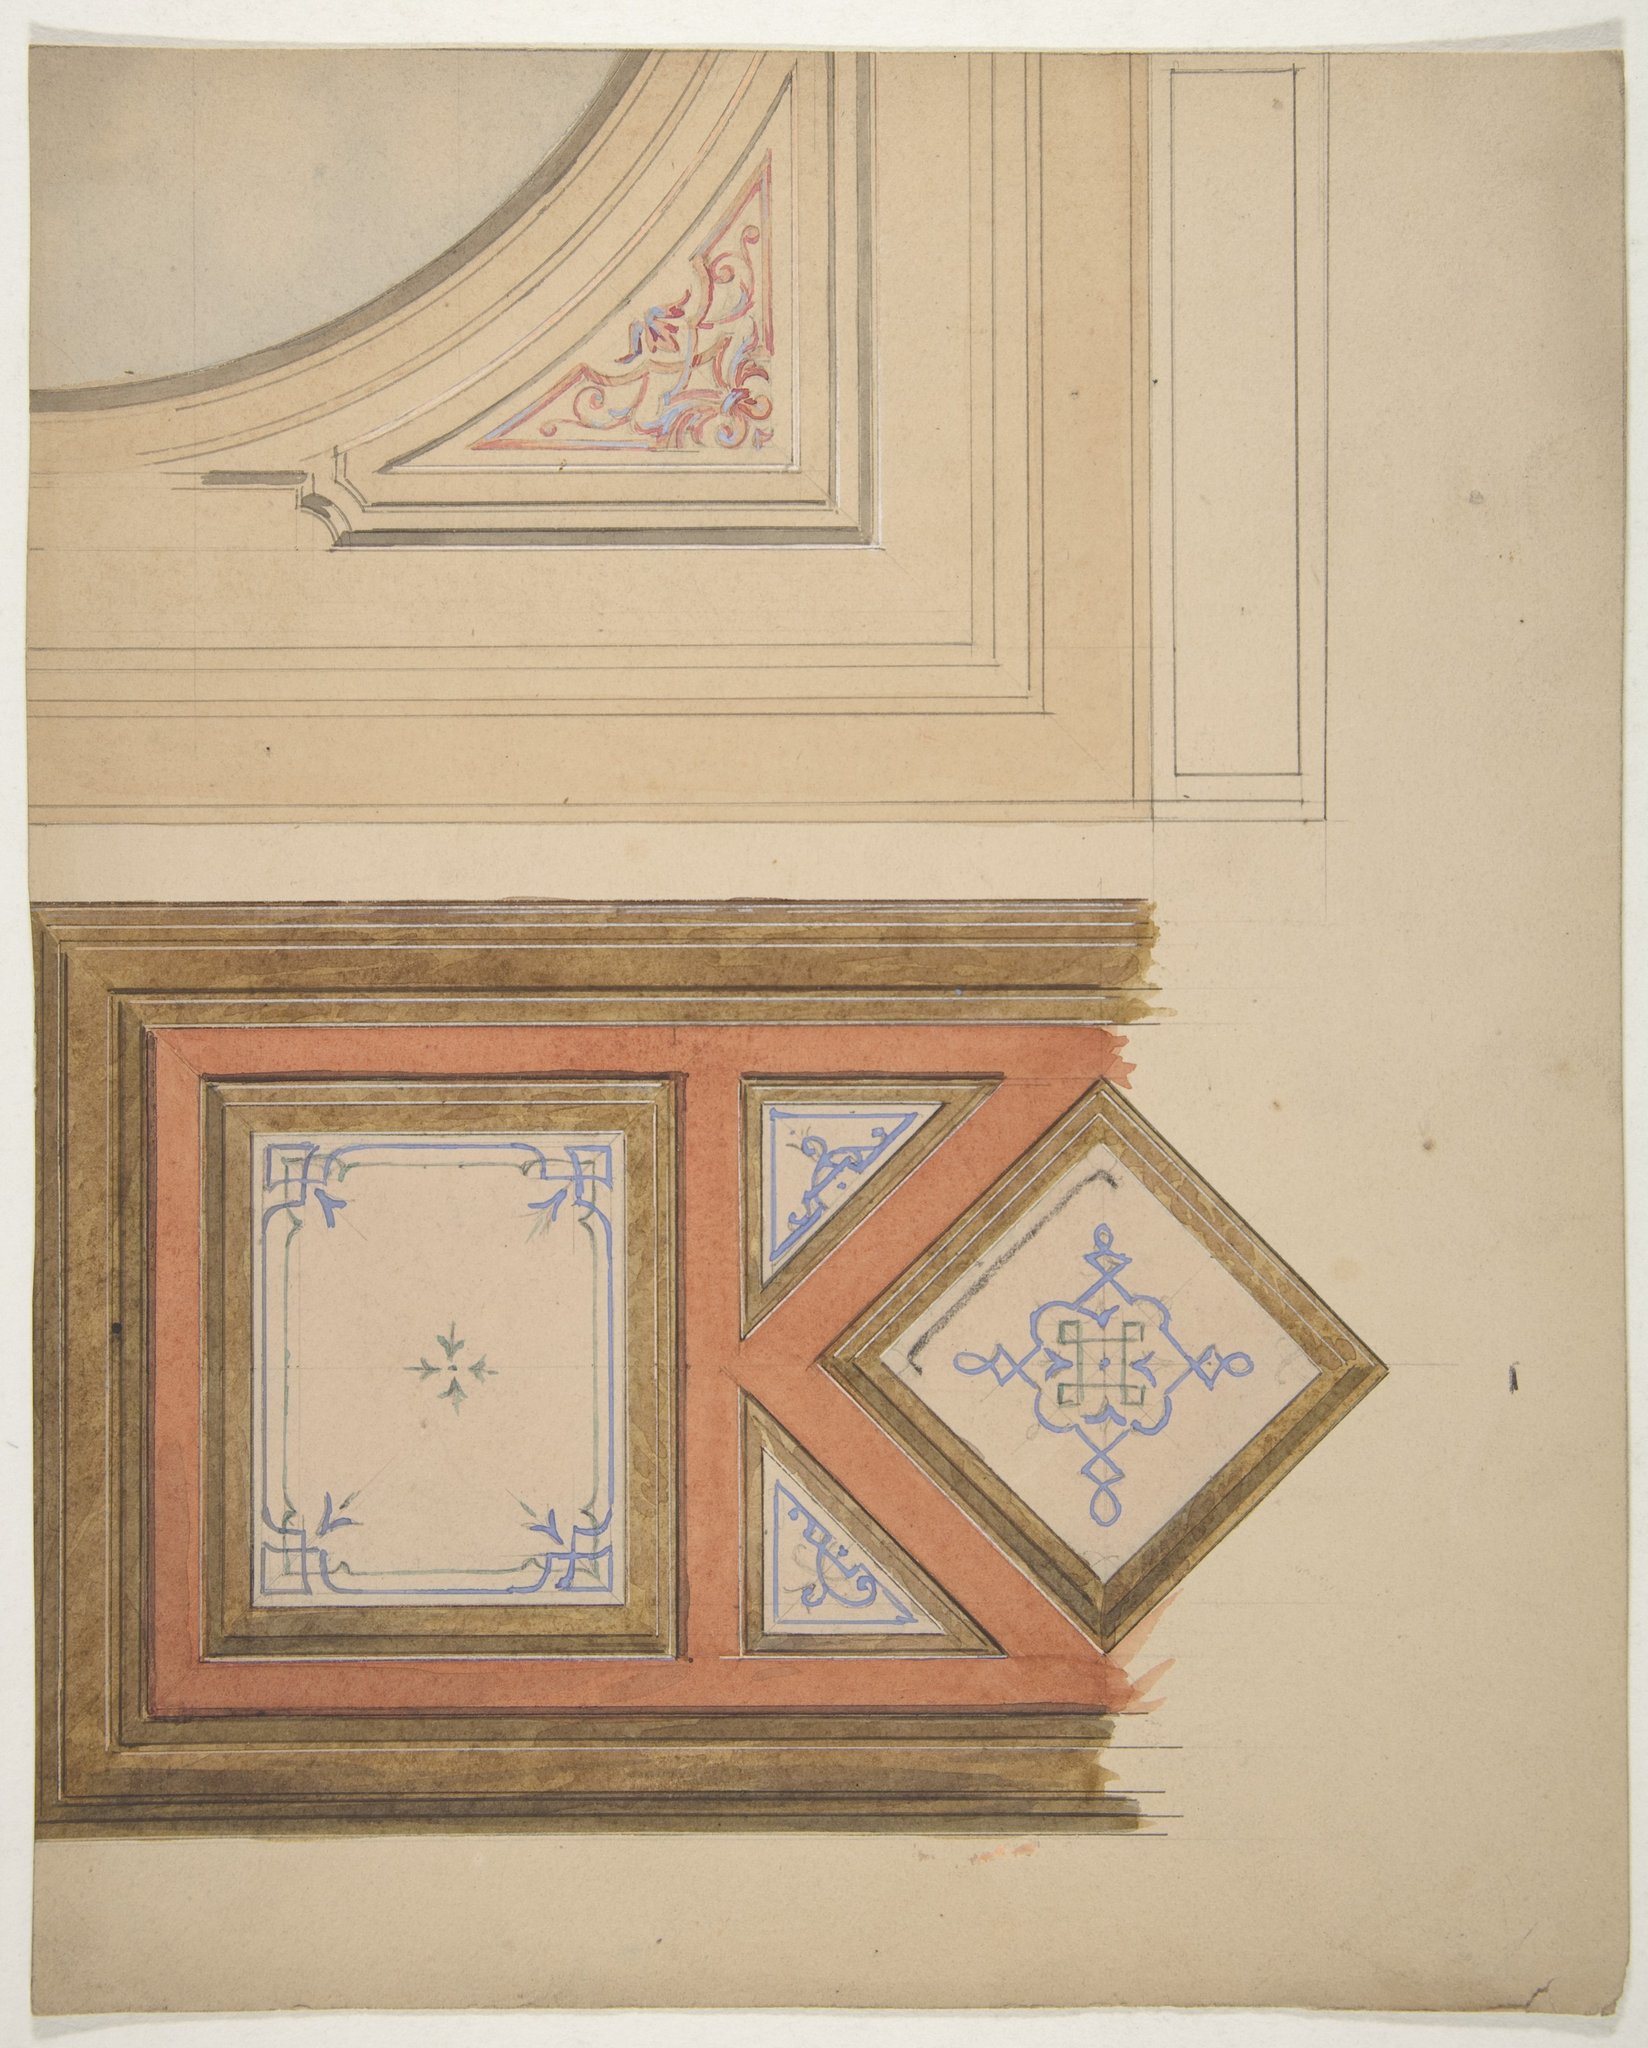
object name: drawing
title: Designs for a ceiling and painted panel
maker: jules-edmond-charles lachaise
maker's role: artist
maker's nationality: french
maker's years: 1897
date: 1830-1897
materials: graphite, ink, watercolor, paper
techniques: pen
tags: ceilings